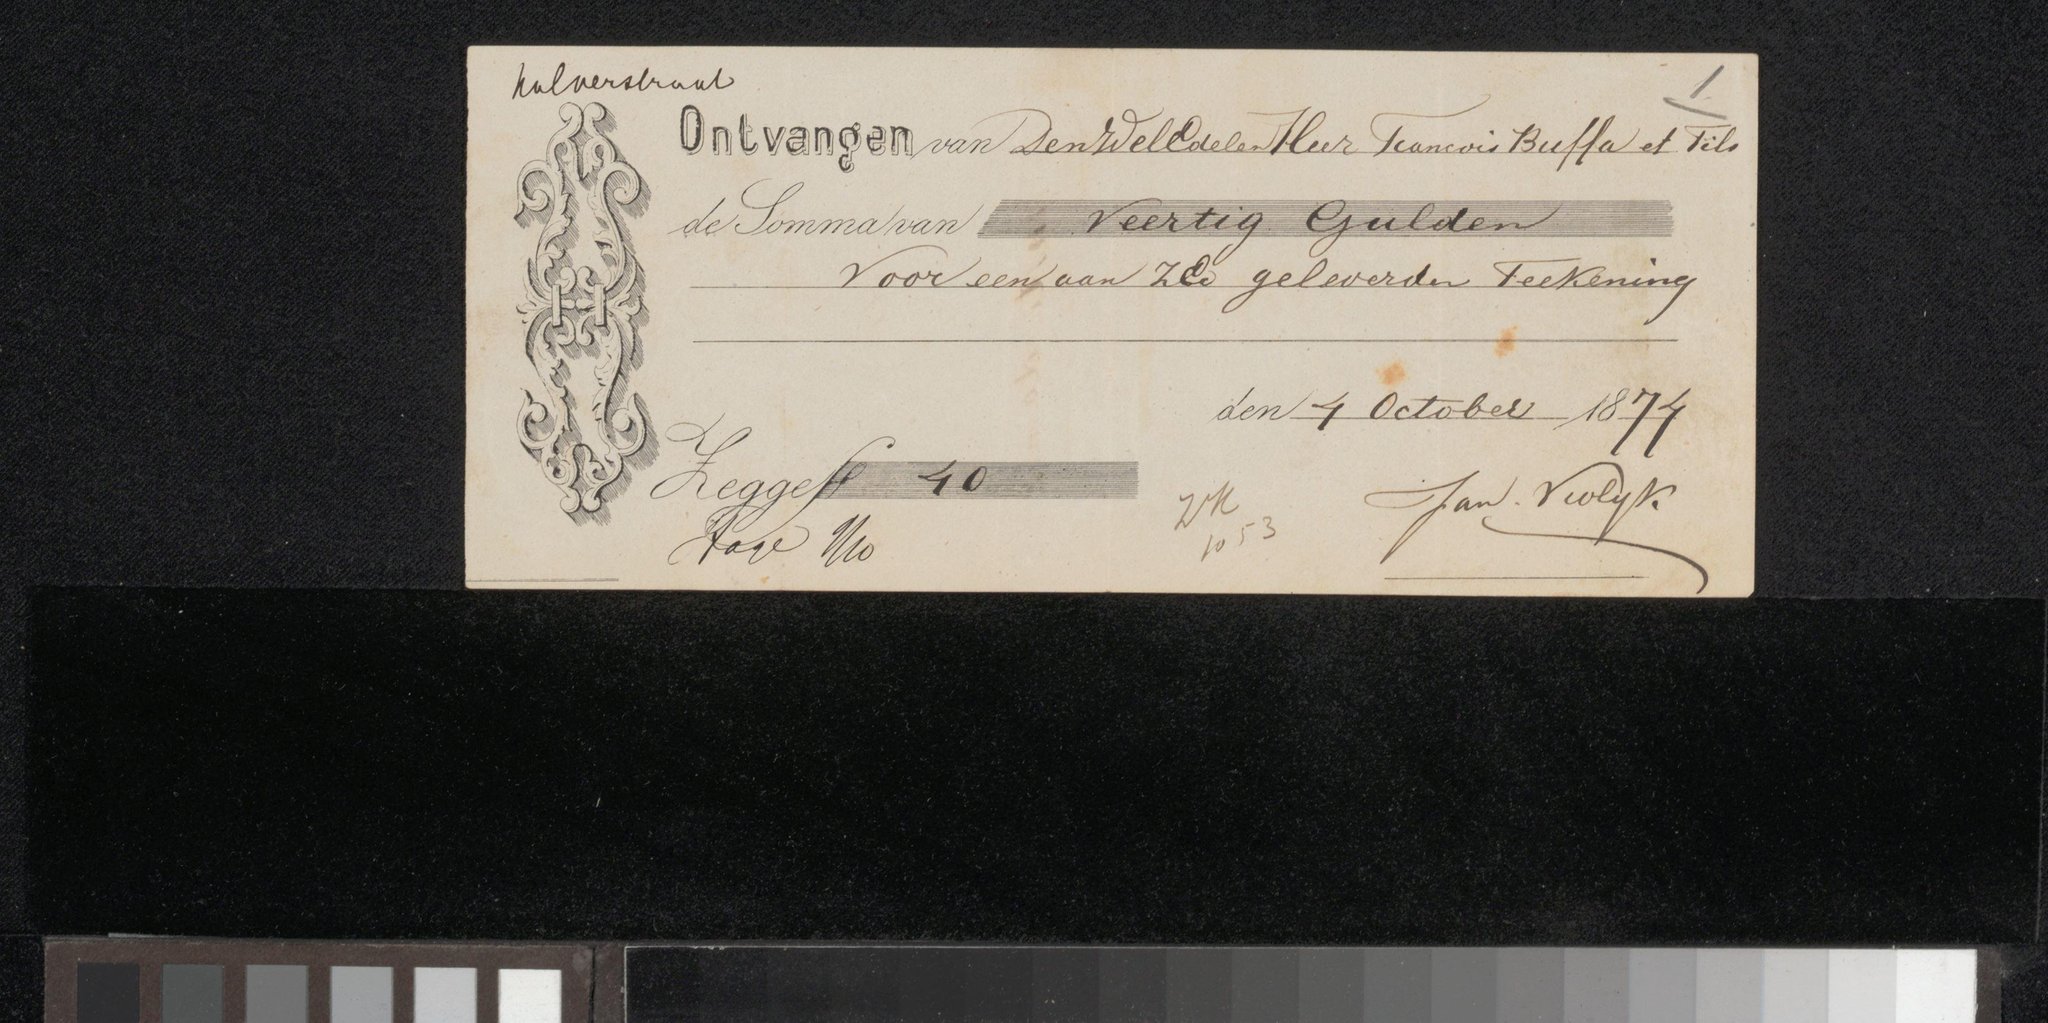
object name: ontvangstbewijs, kwitantie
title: Kwitantie voor Jan Vrolijk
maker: jan vrolijk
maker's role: draughtsman, painter, print maker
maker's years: 1846-1894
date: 1874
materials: ink, paper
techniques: pen, printing, writing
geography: amsterdam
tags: drawing, money